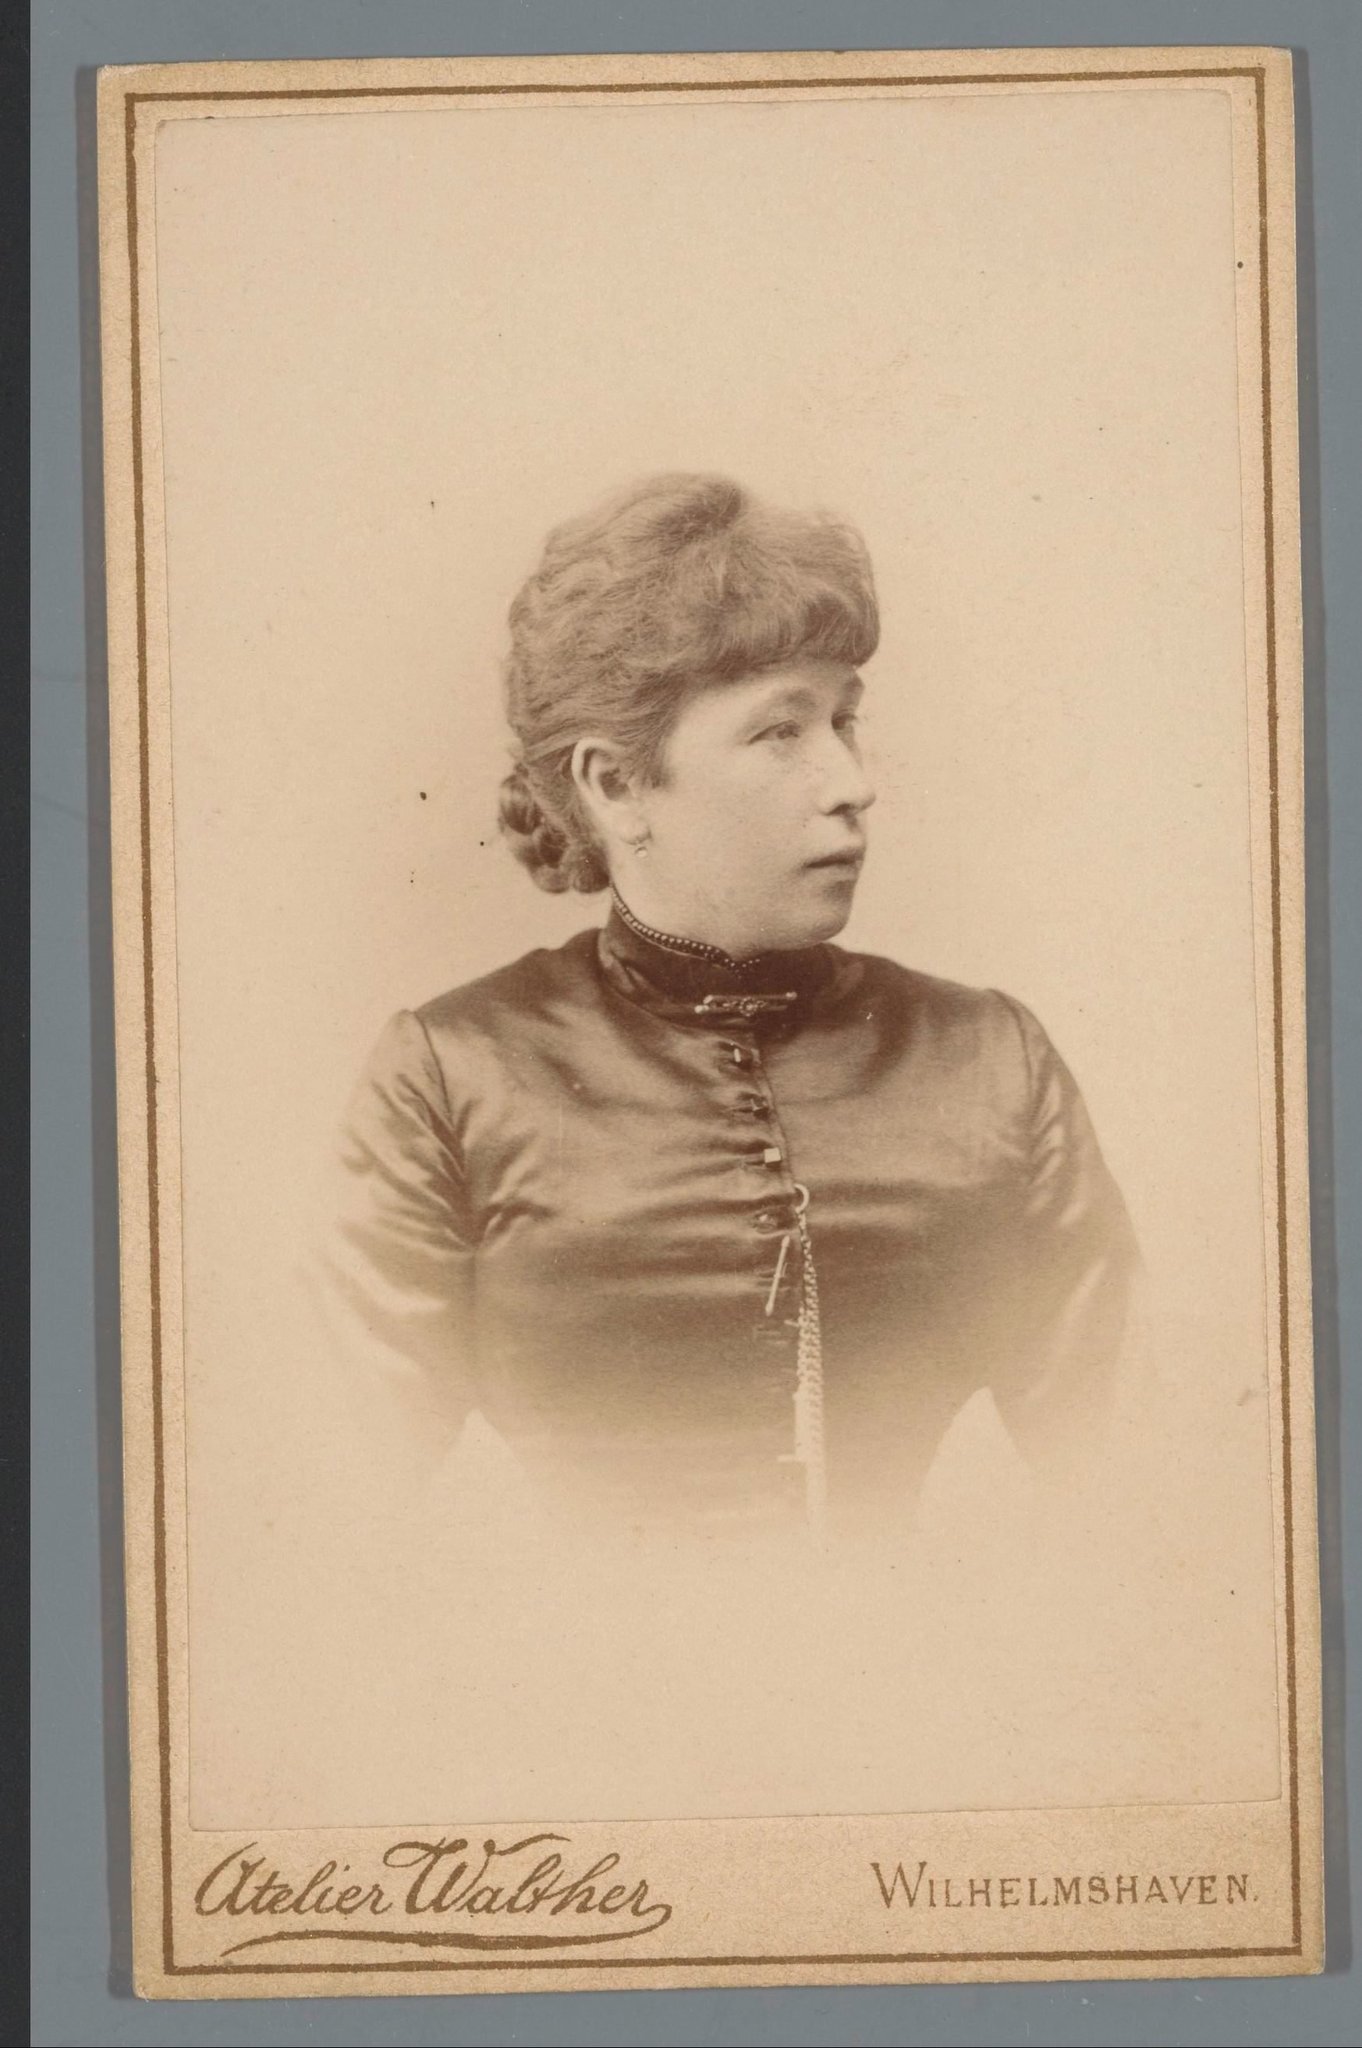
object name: carte de visite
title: Portret van een onbekende vrouw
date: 1855-1885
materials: cardboard, paper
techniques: albumen print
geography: wilhelmshaven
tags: adult woman, anonymous historical person portrayed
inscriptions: address: ‘Wilhelmshaven/ Roon-Str.’, inscription: ‘Die Platte bleibt zum Nachbestellen 2 Jahr aufbewahrt./ Brandi & Wilde Berlin, S-O.’